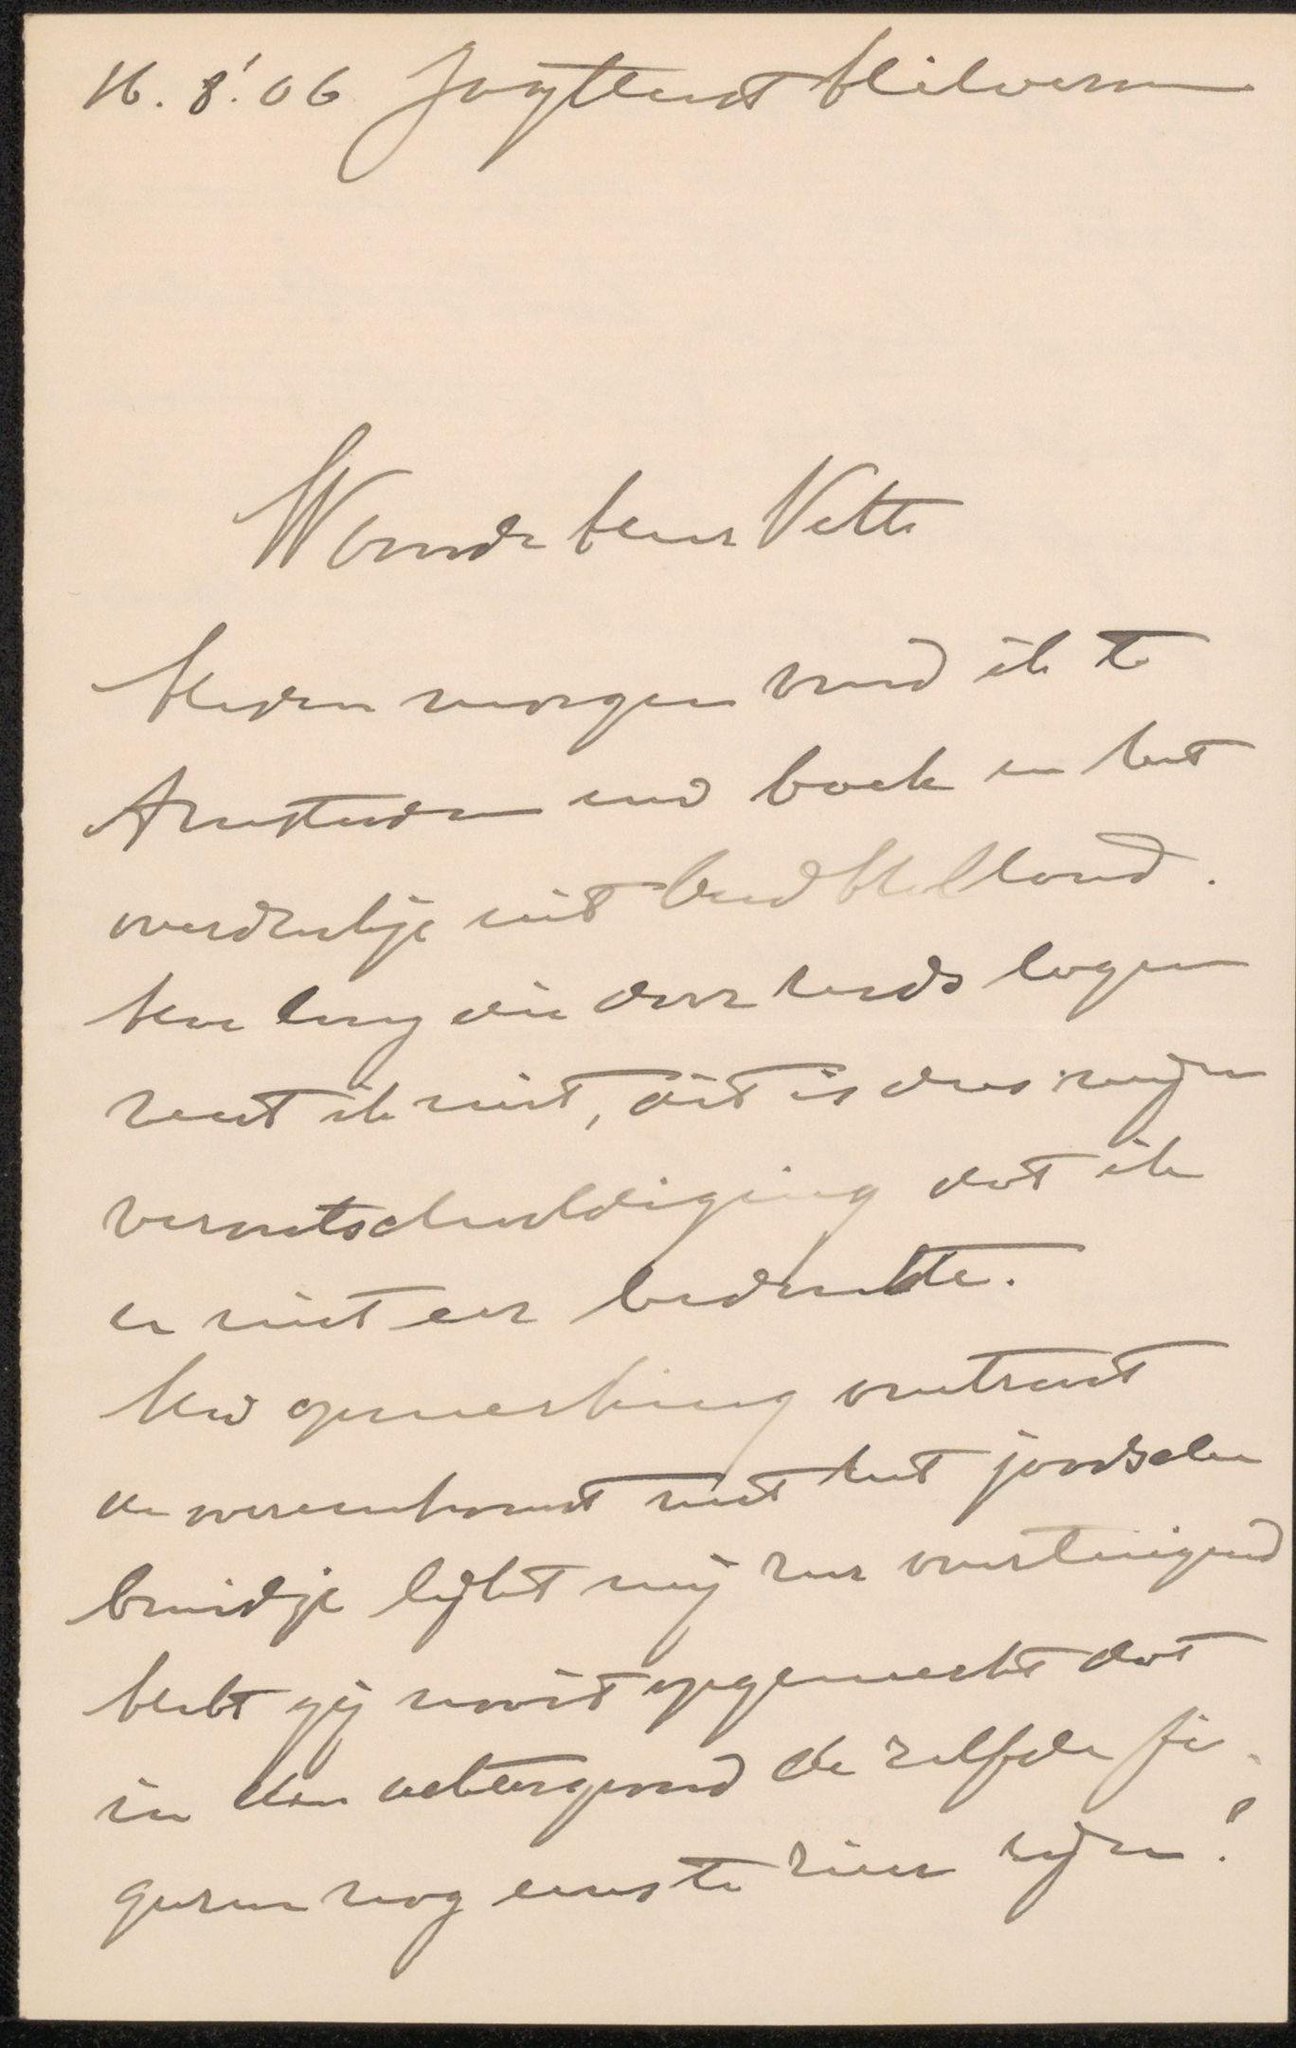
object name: letter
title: Brief aan Jan Veth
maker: jonkheer jan six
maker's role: hoogleraar, kunsthistoricus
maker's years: 1857-1926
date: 1906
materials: ink, paper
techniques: pen, writing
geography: hilversum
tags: dordrecht, designer, jan veth, leiden, painter, print maker, draughtsman, rembrandt van rijn, printed matter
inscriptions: watermark, collector's mark: ‘RPK’